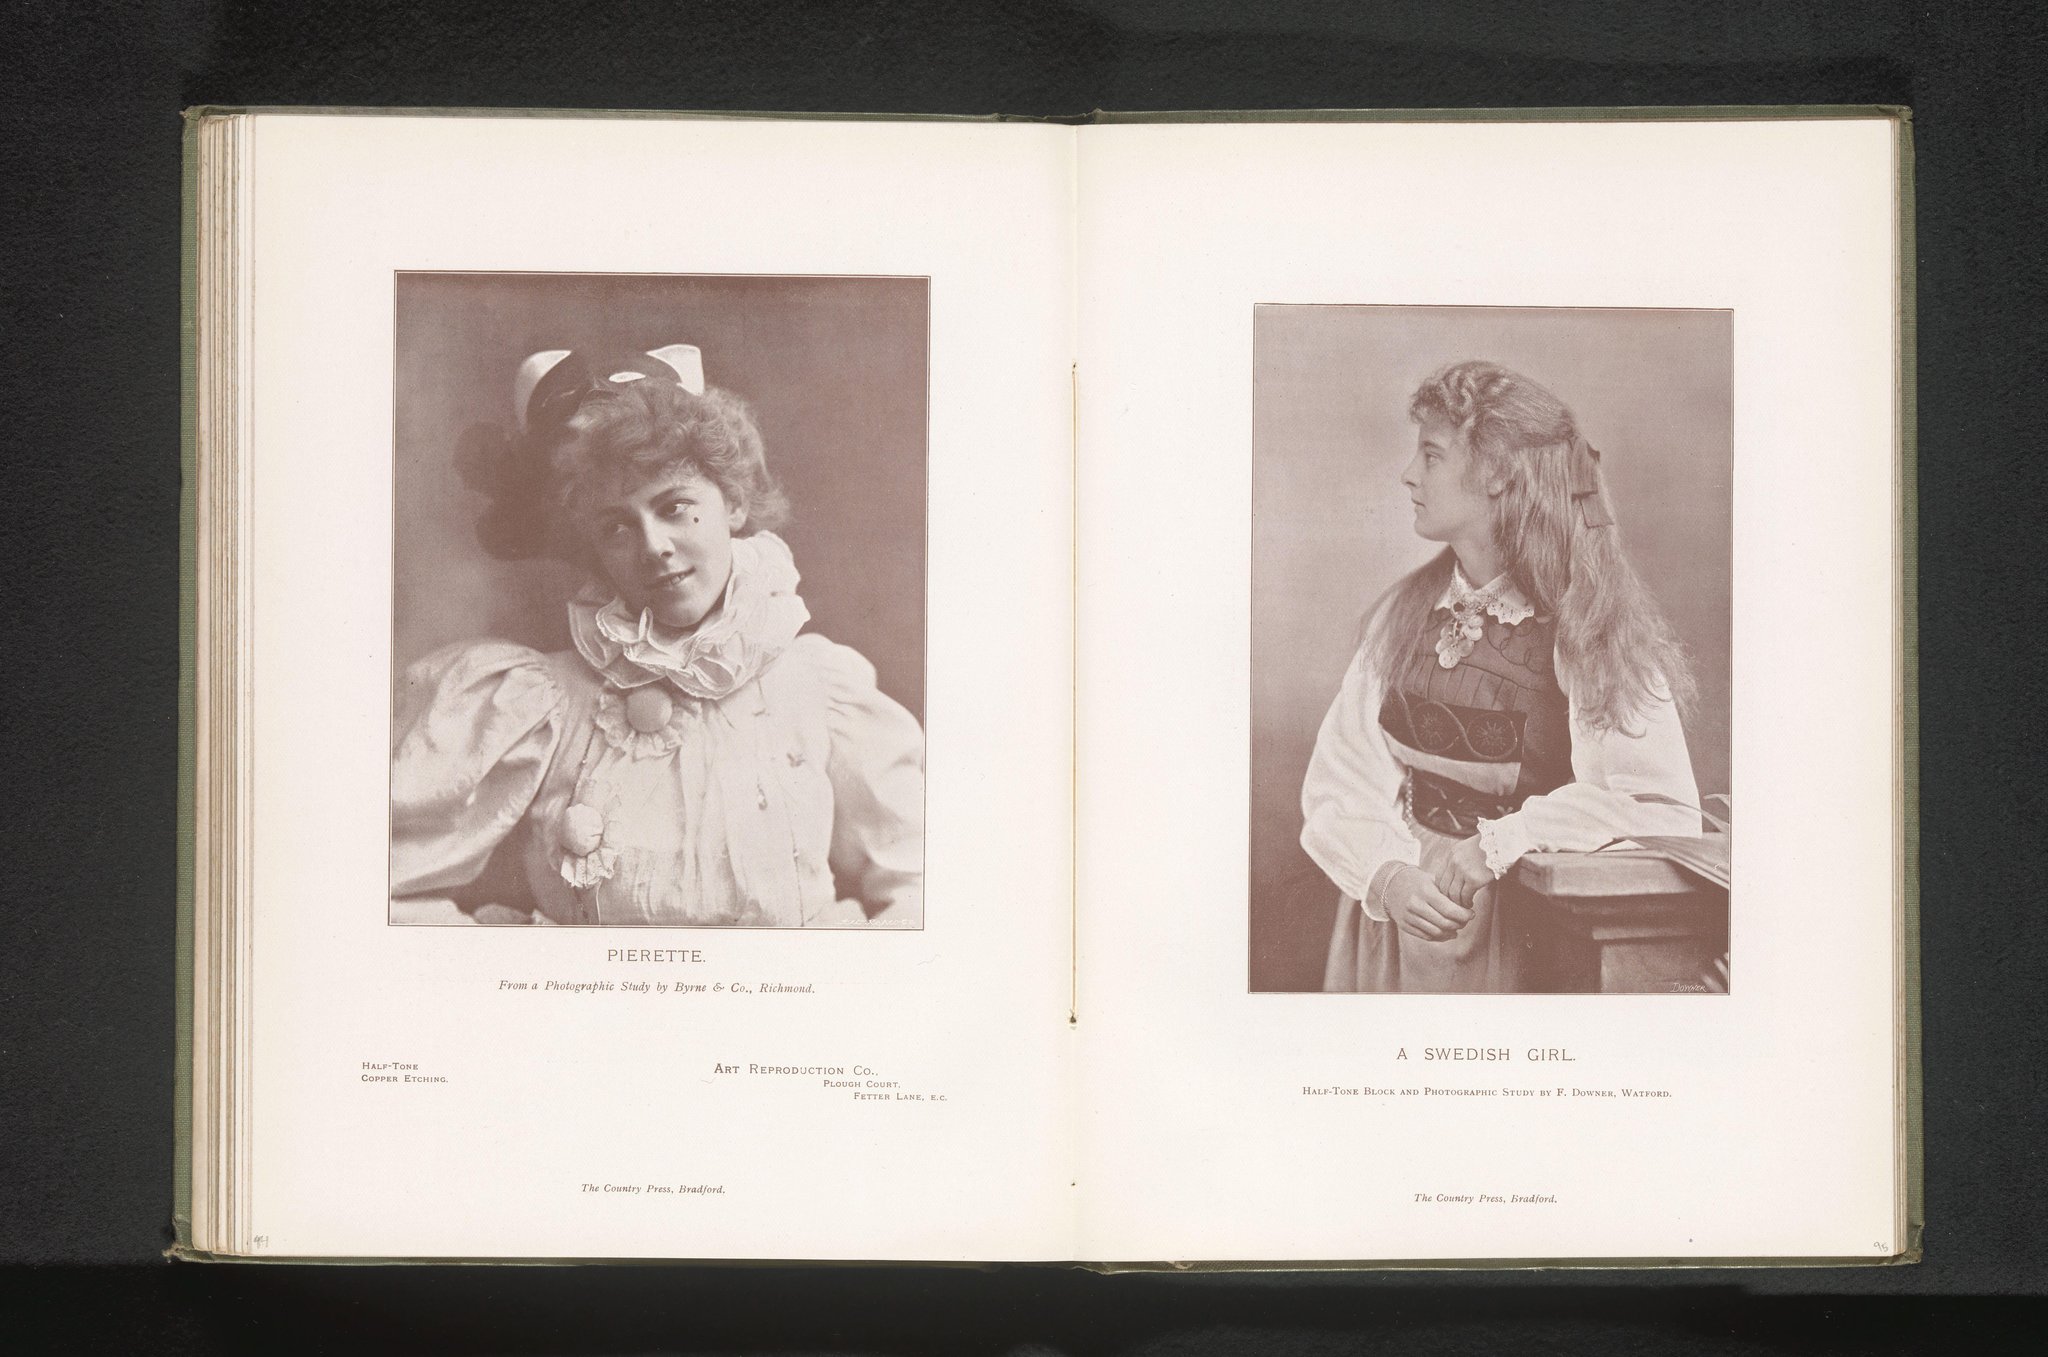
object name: page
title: Portret van een onbekend Zweeds meisje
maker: frederick downer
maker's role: clichémaker, fotograaf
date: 1893-1898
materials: paper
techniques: autotype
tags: adolescent, young woman, maiden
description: Prent op vijfde ongenummerde pagina na pagina 108.